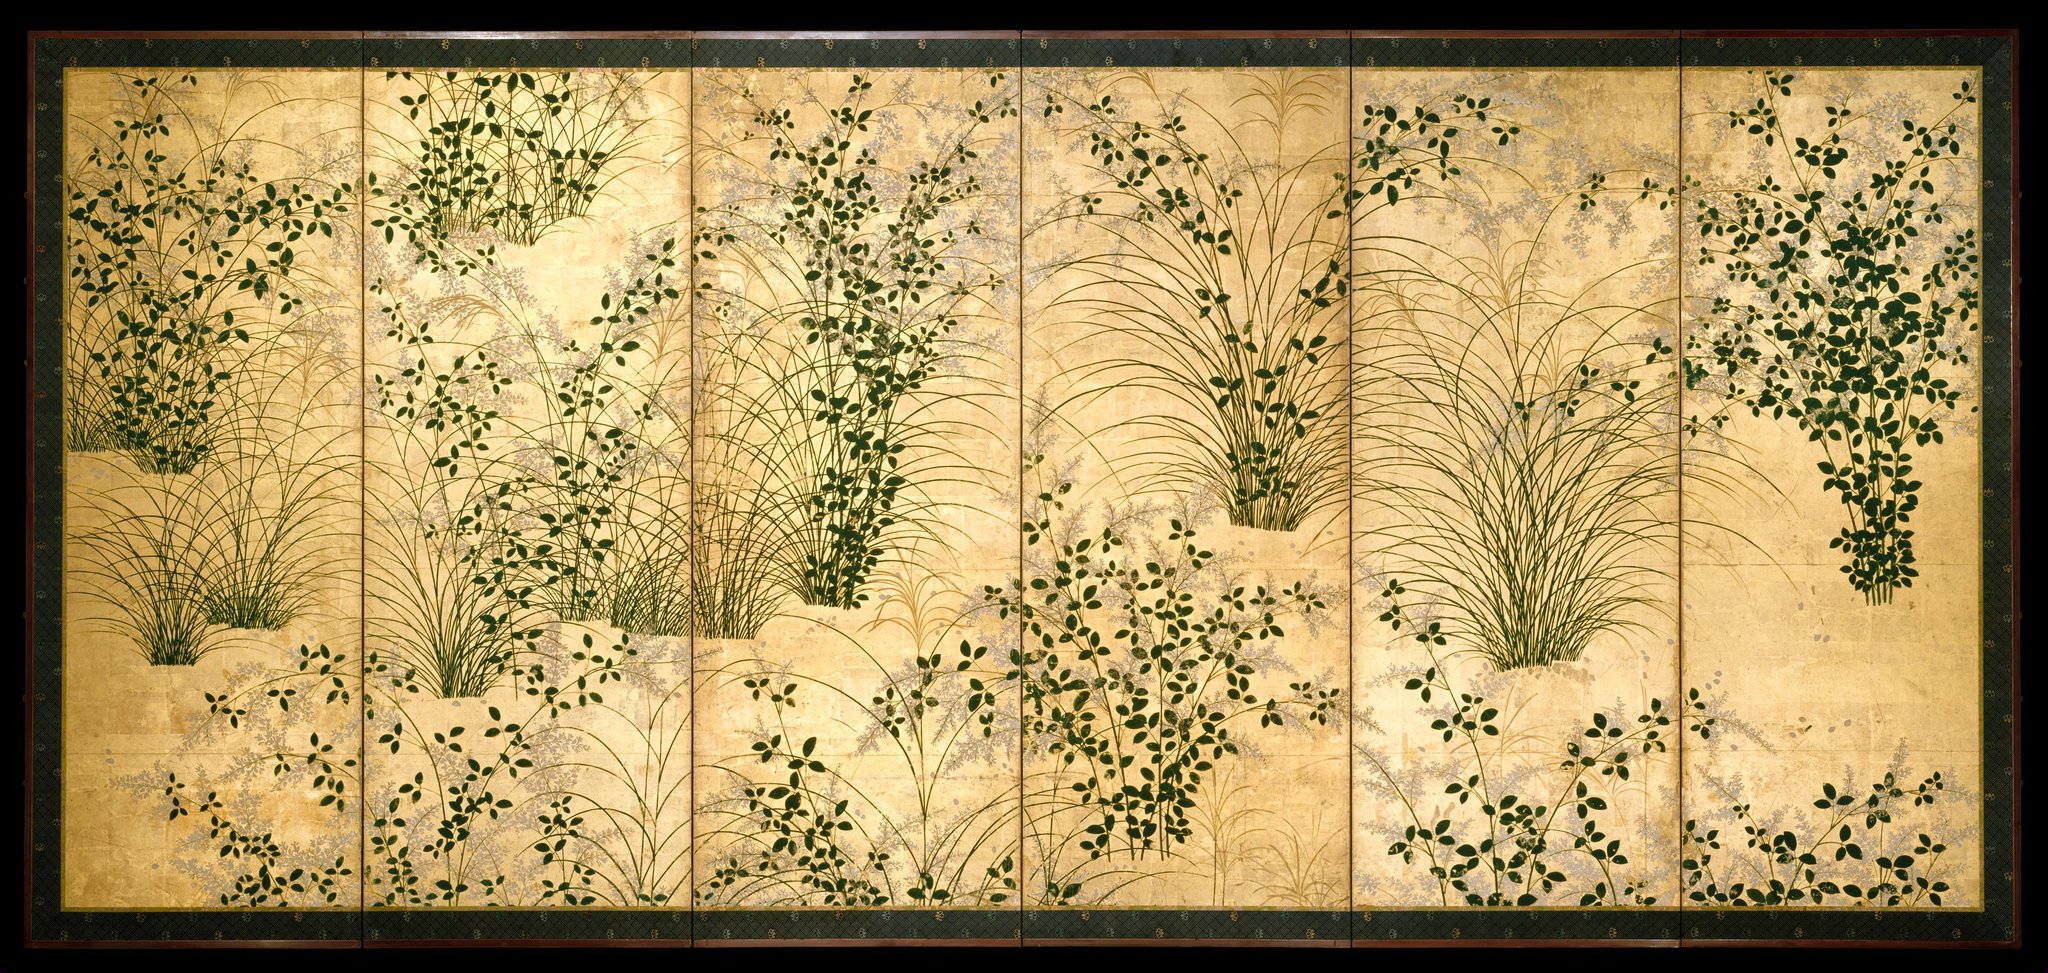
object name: screen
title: Autumn Grasses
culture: japanese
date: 1601-1650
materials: gilt, ink, panel, paper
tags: leaves,autumn